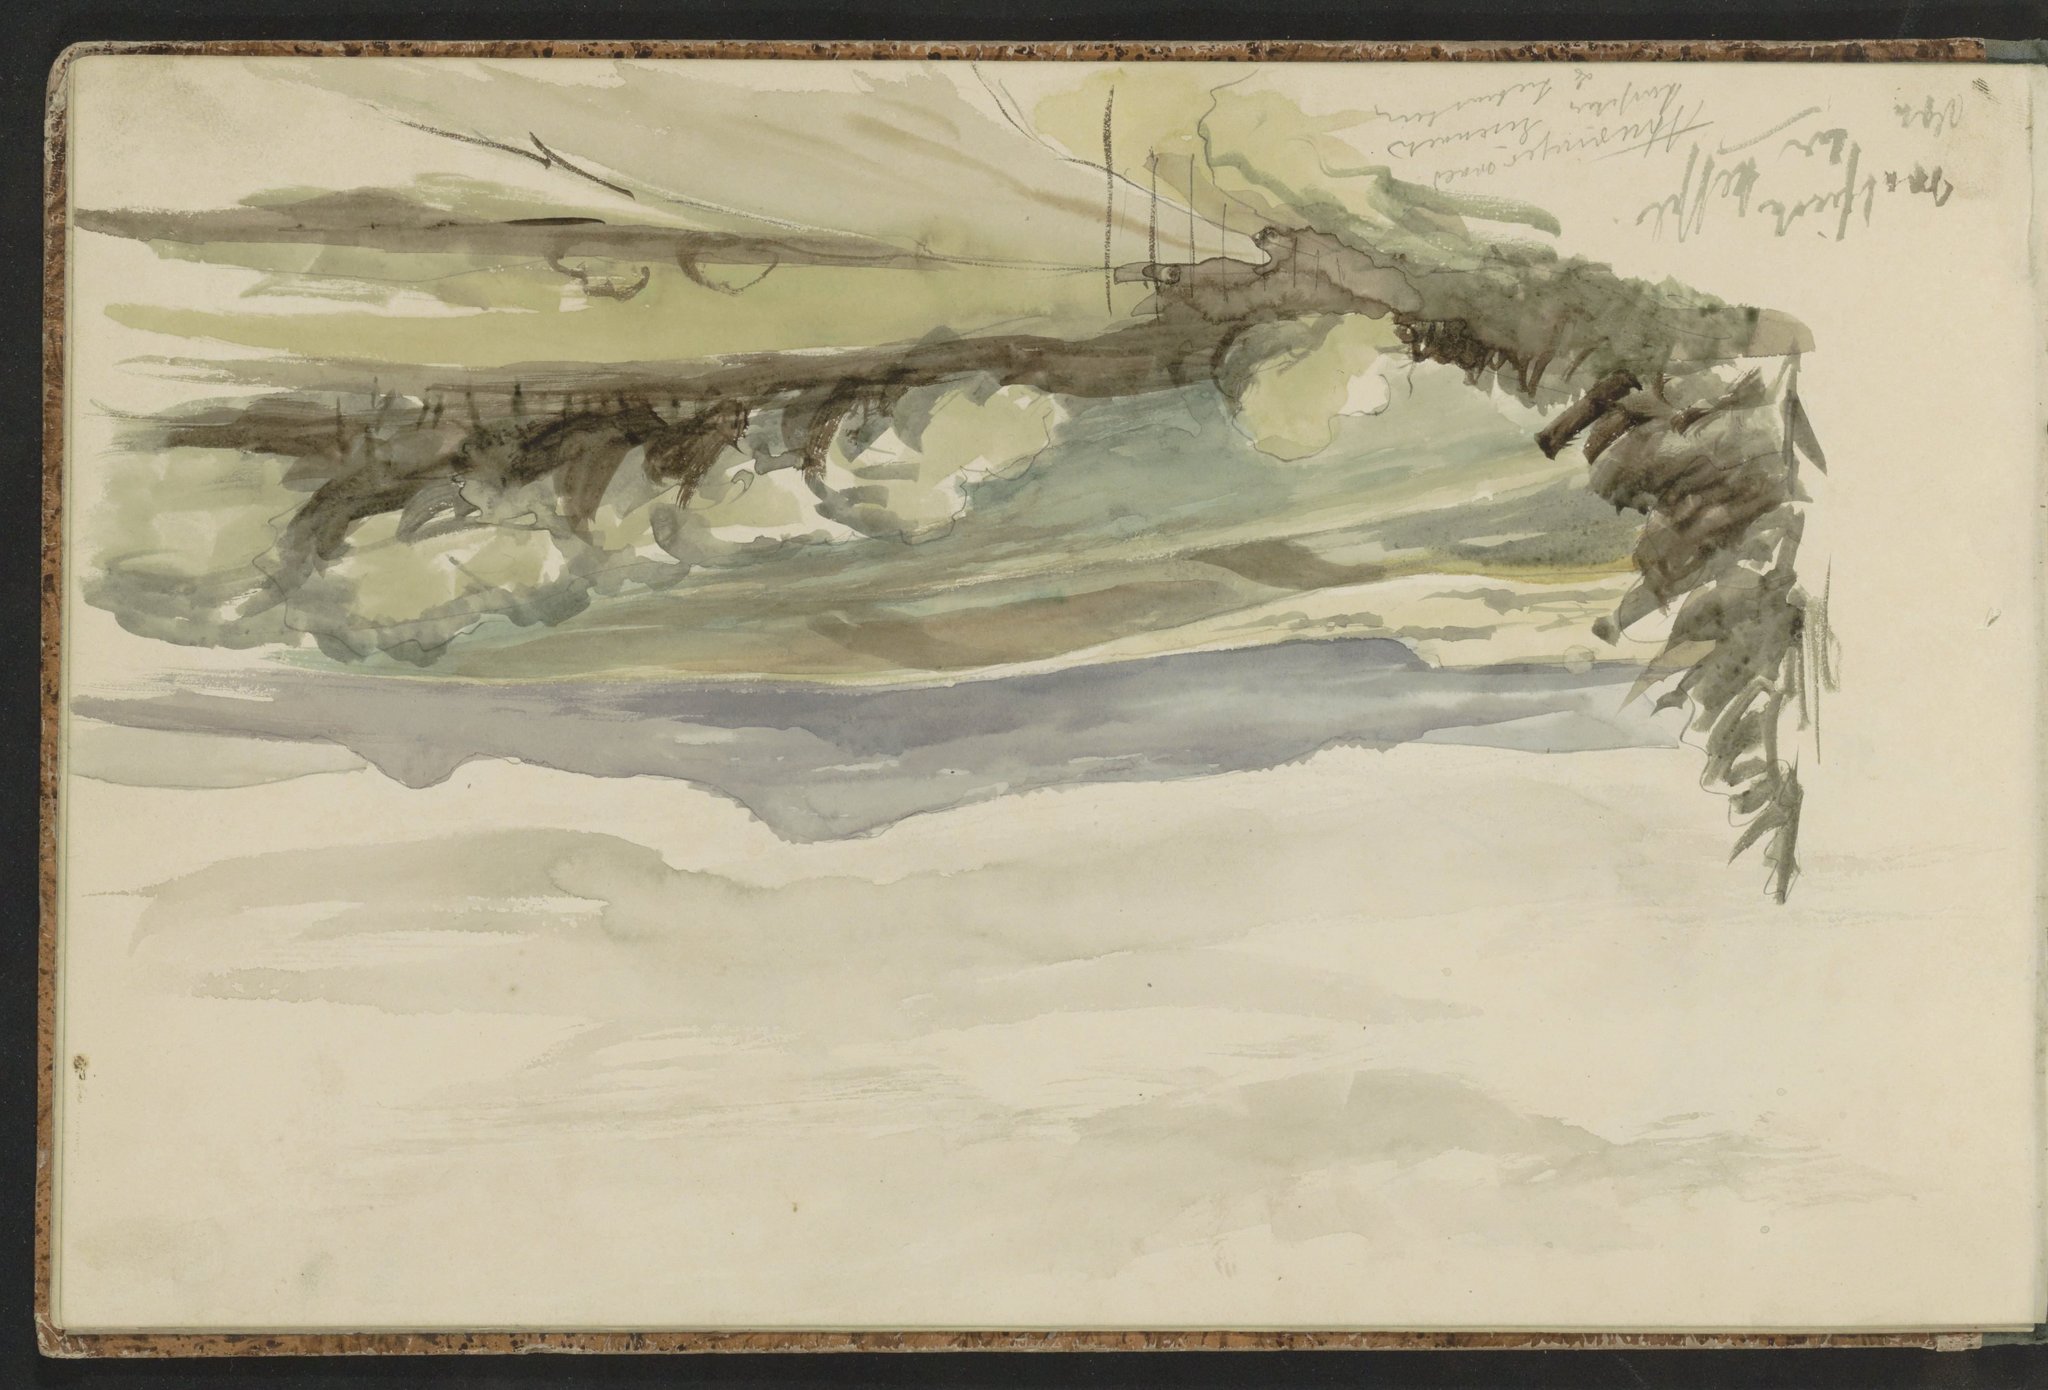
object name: sketchbook leaf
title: Berglandschap in het Thüringer Wald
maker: johannes tavenraat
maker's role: draughtsman, painter, print maker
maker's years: 1809-1881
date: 1840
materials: paper, pencil, watercolor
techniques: brush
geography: schwarzburg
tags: forest, wood, mountains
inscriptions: annotation: ‘ma[...]/ van der ke[...]/ Thuringer wald/ [...]Eisenach/ & Liebenstein’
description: Blad 6 verso uit een schetsboek met 33 bladen.